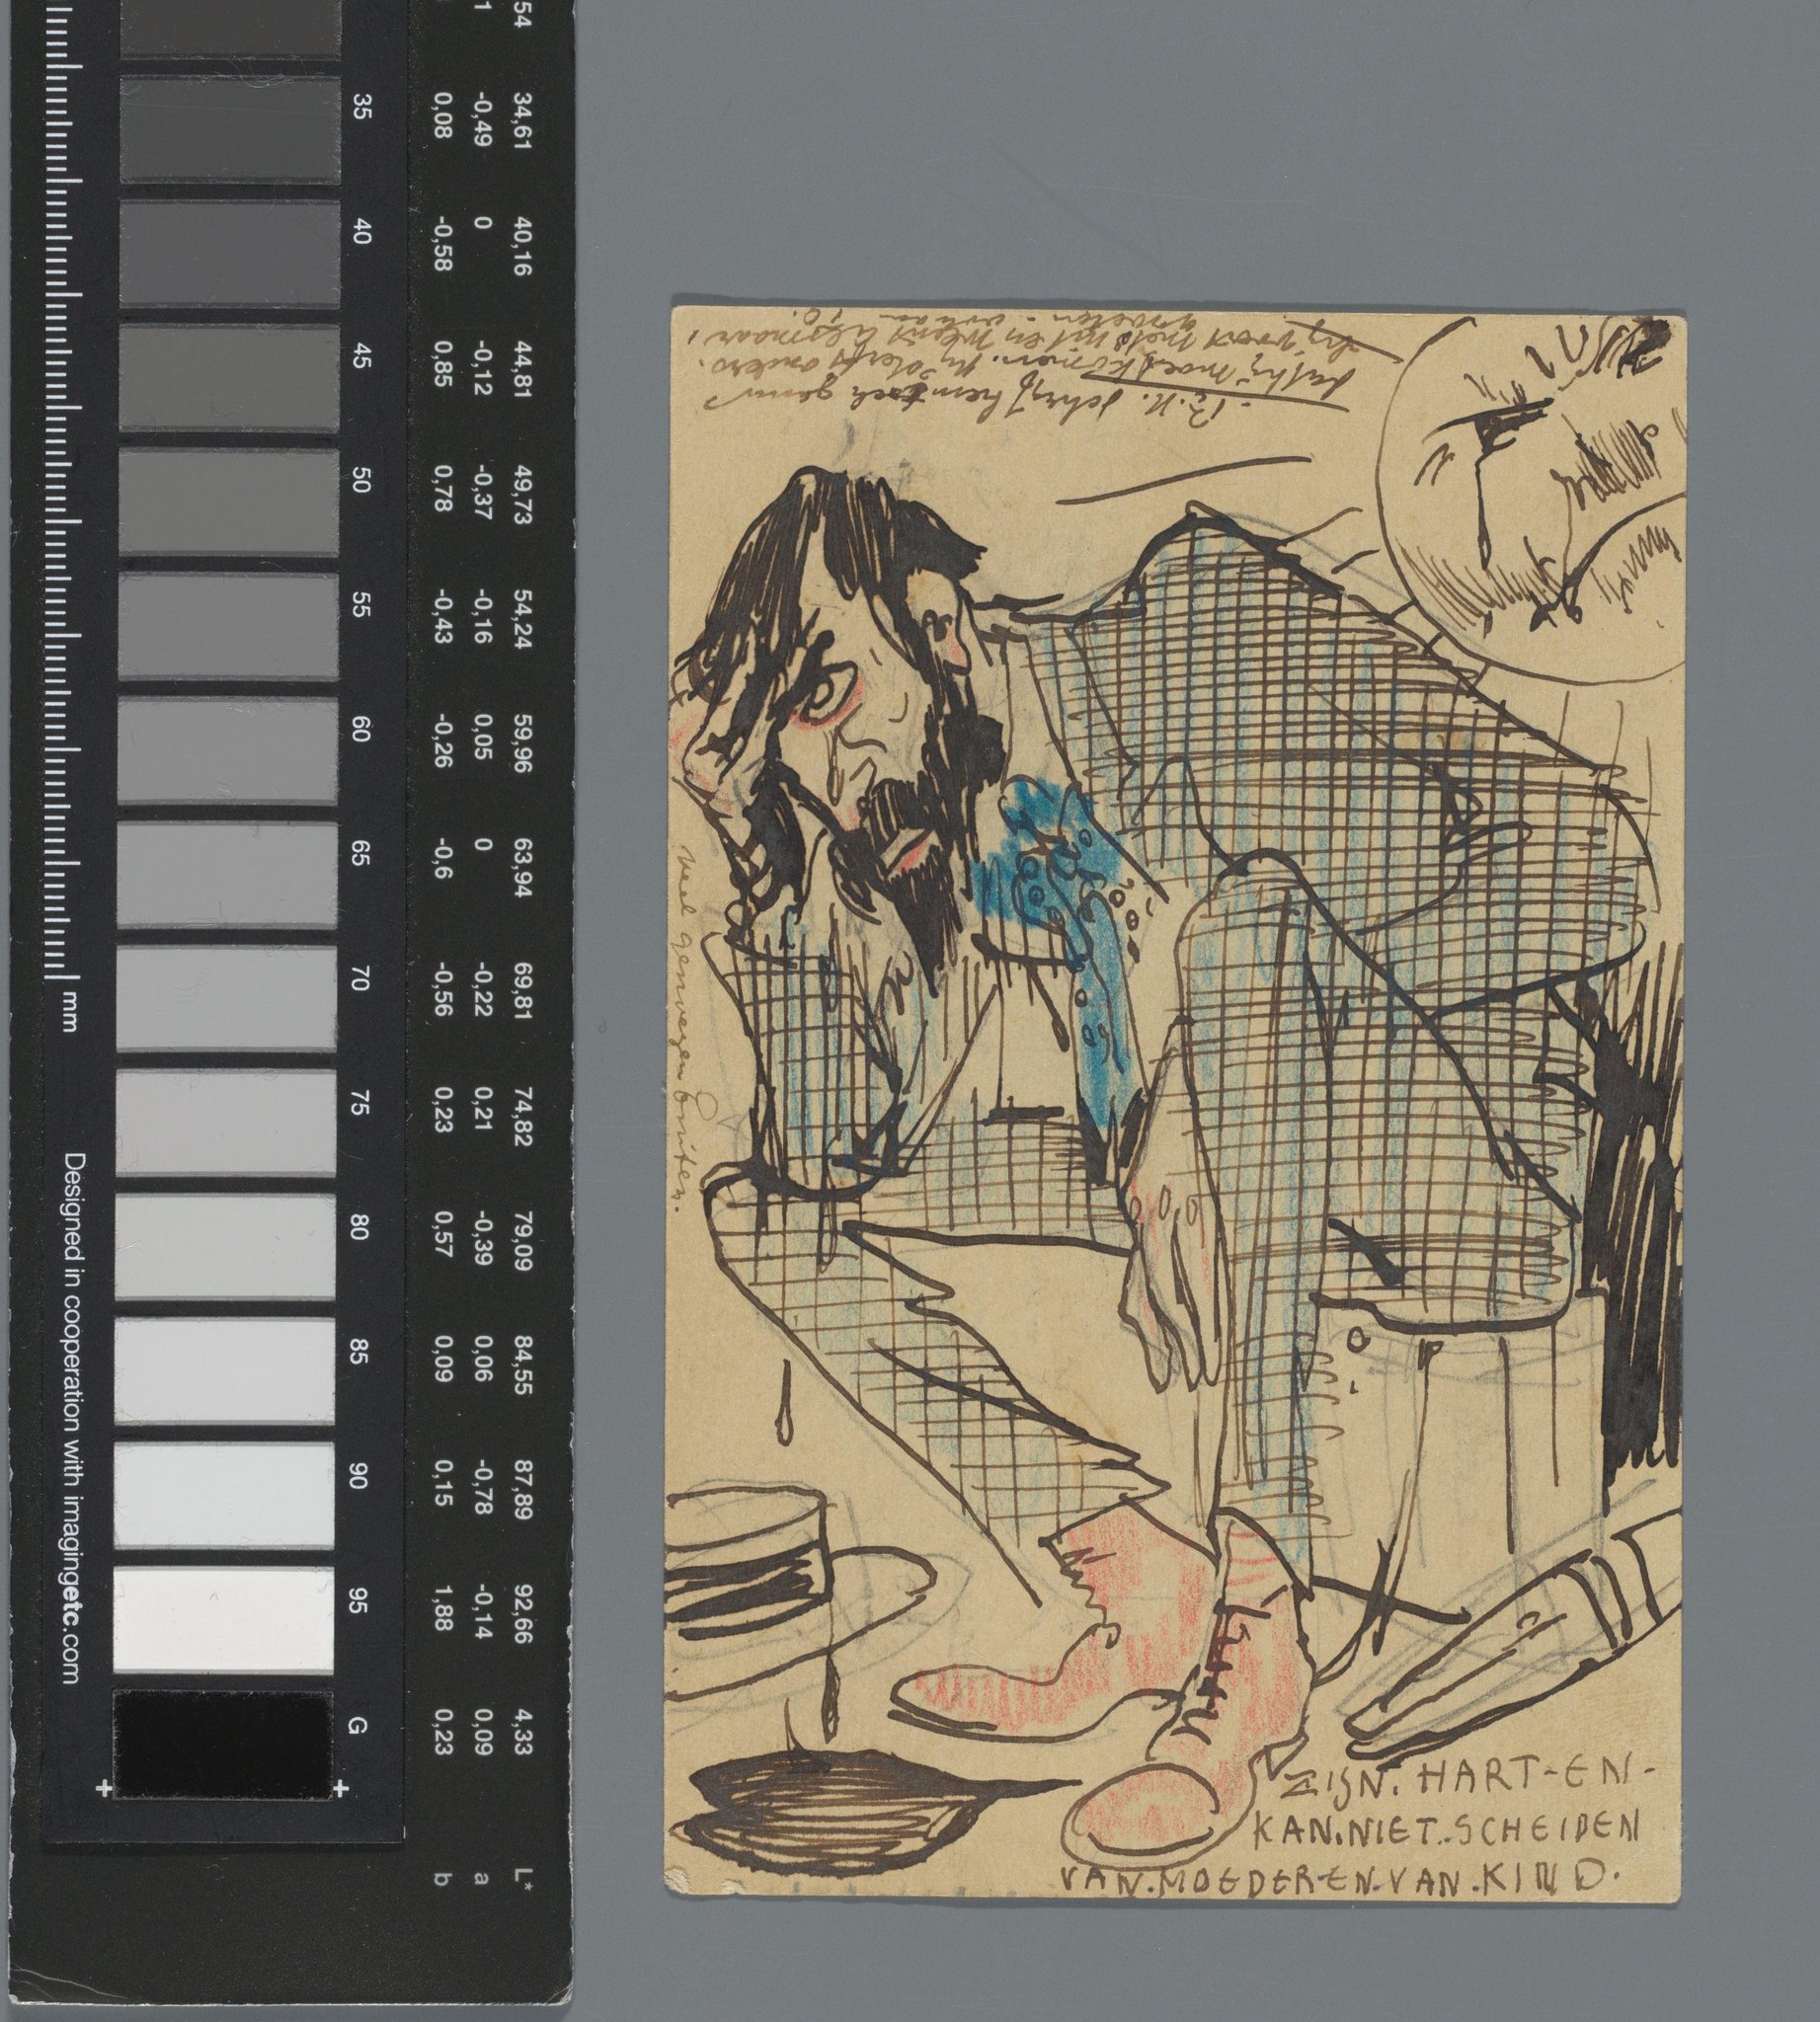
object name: drawing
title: Briefkaart aan Henriëtte Johanna Petronella van Hilten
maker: leo gestel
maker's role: draughtsman, print maker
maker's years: 1881-1941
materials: cardboard, ink, pencil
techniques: pen, writing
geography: amsterdam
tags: henriëtte johanna petronella ponstijn-van hilten, amsterdam, print maker, draughtsman, jan petrus ponstijn, weeping, portrait, self-portrait of artist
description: Briefkaart met een tekening van Jan Ponstijn die op een koffer zit te huilen met zijn hand tegen zijn hoofd. Op de achtergrond een zon met een grimas. Briefkaart maakt deel uit van een album.